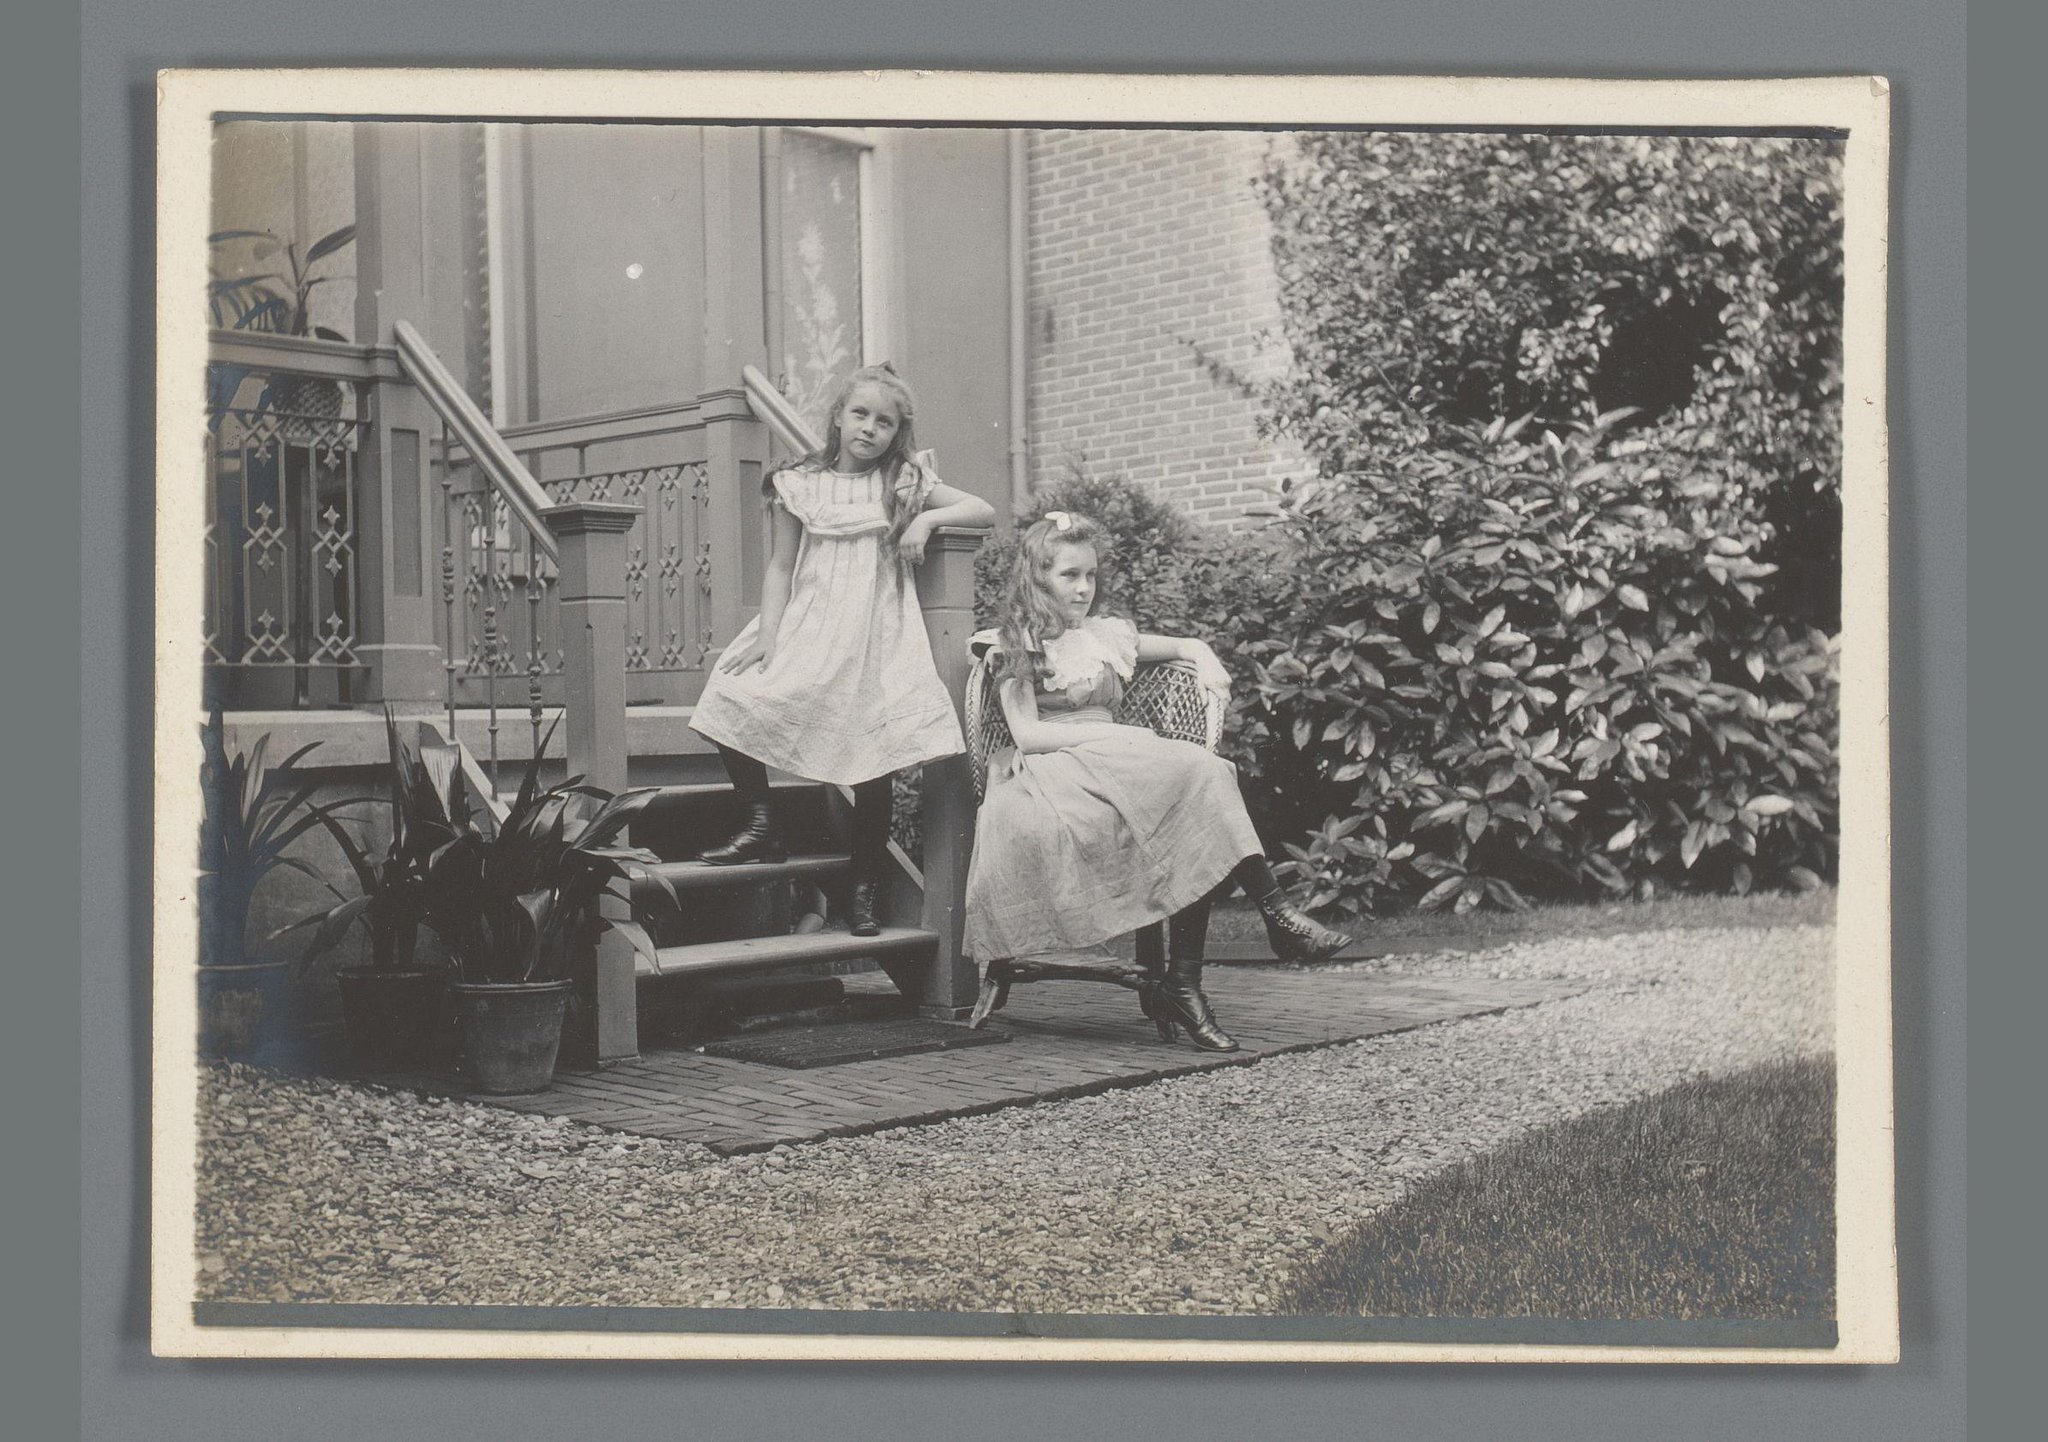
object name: photograph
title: Portret van Johanna (Hans) de Jong en Johanna (Nan) Vreede in de tuin van Piet en Hendrina (Dina) de Jong in Arnhem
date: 1905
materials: paper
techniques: gelatin silver print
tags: leiden, johanna petronella lambertina stokhuyzen-de jong (hans), johanna elisabeth borgerhoff mulder-vreede (nan), historical persons, girl (child between toddler and youth)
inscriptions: inscription: ‘Nan = zittend/ H./ Velperplein 14’